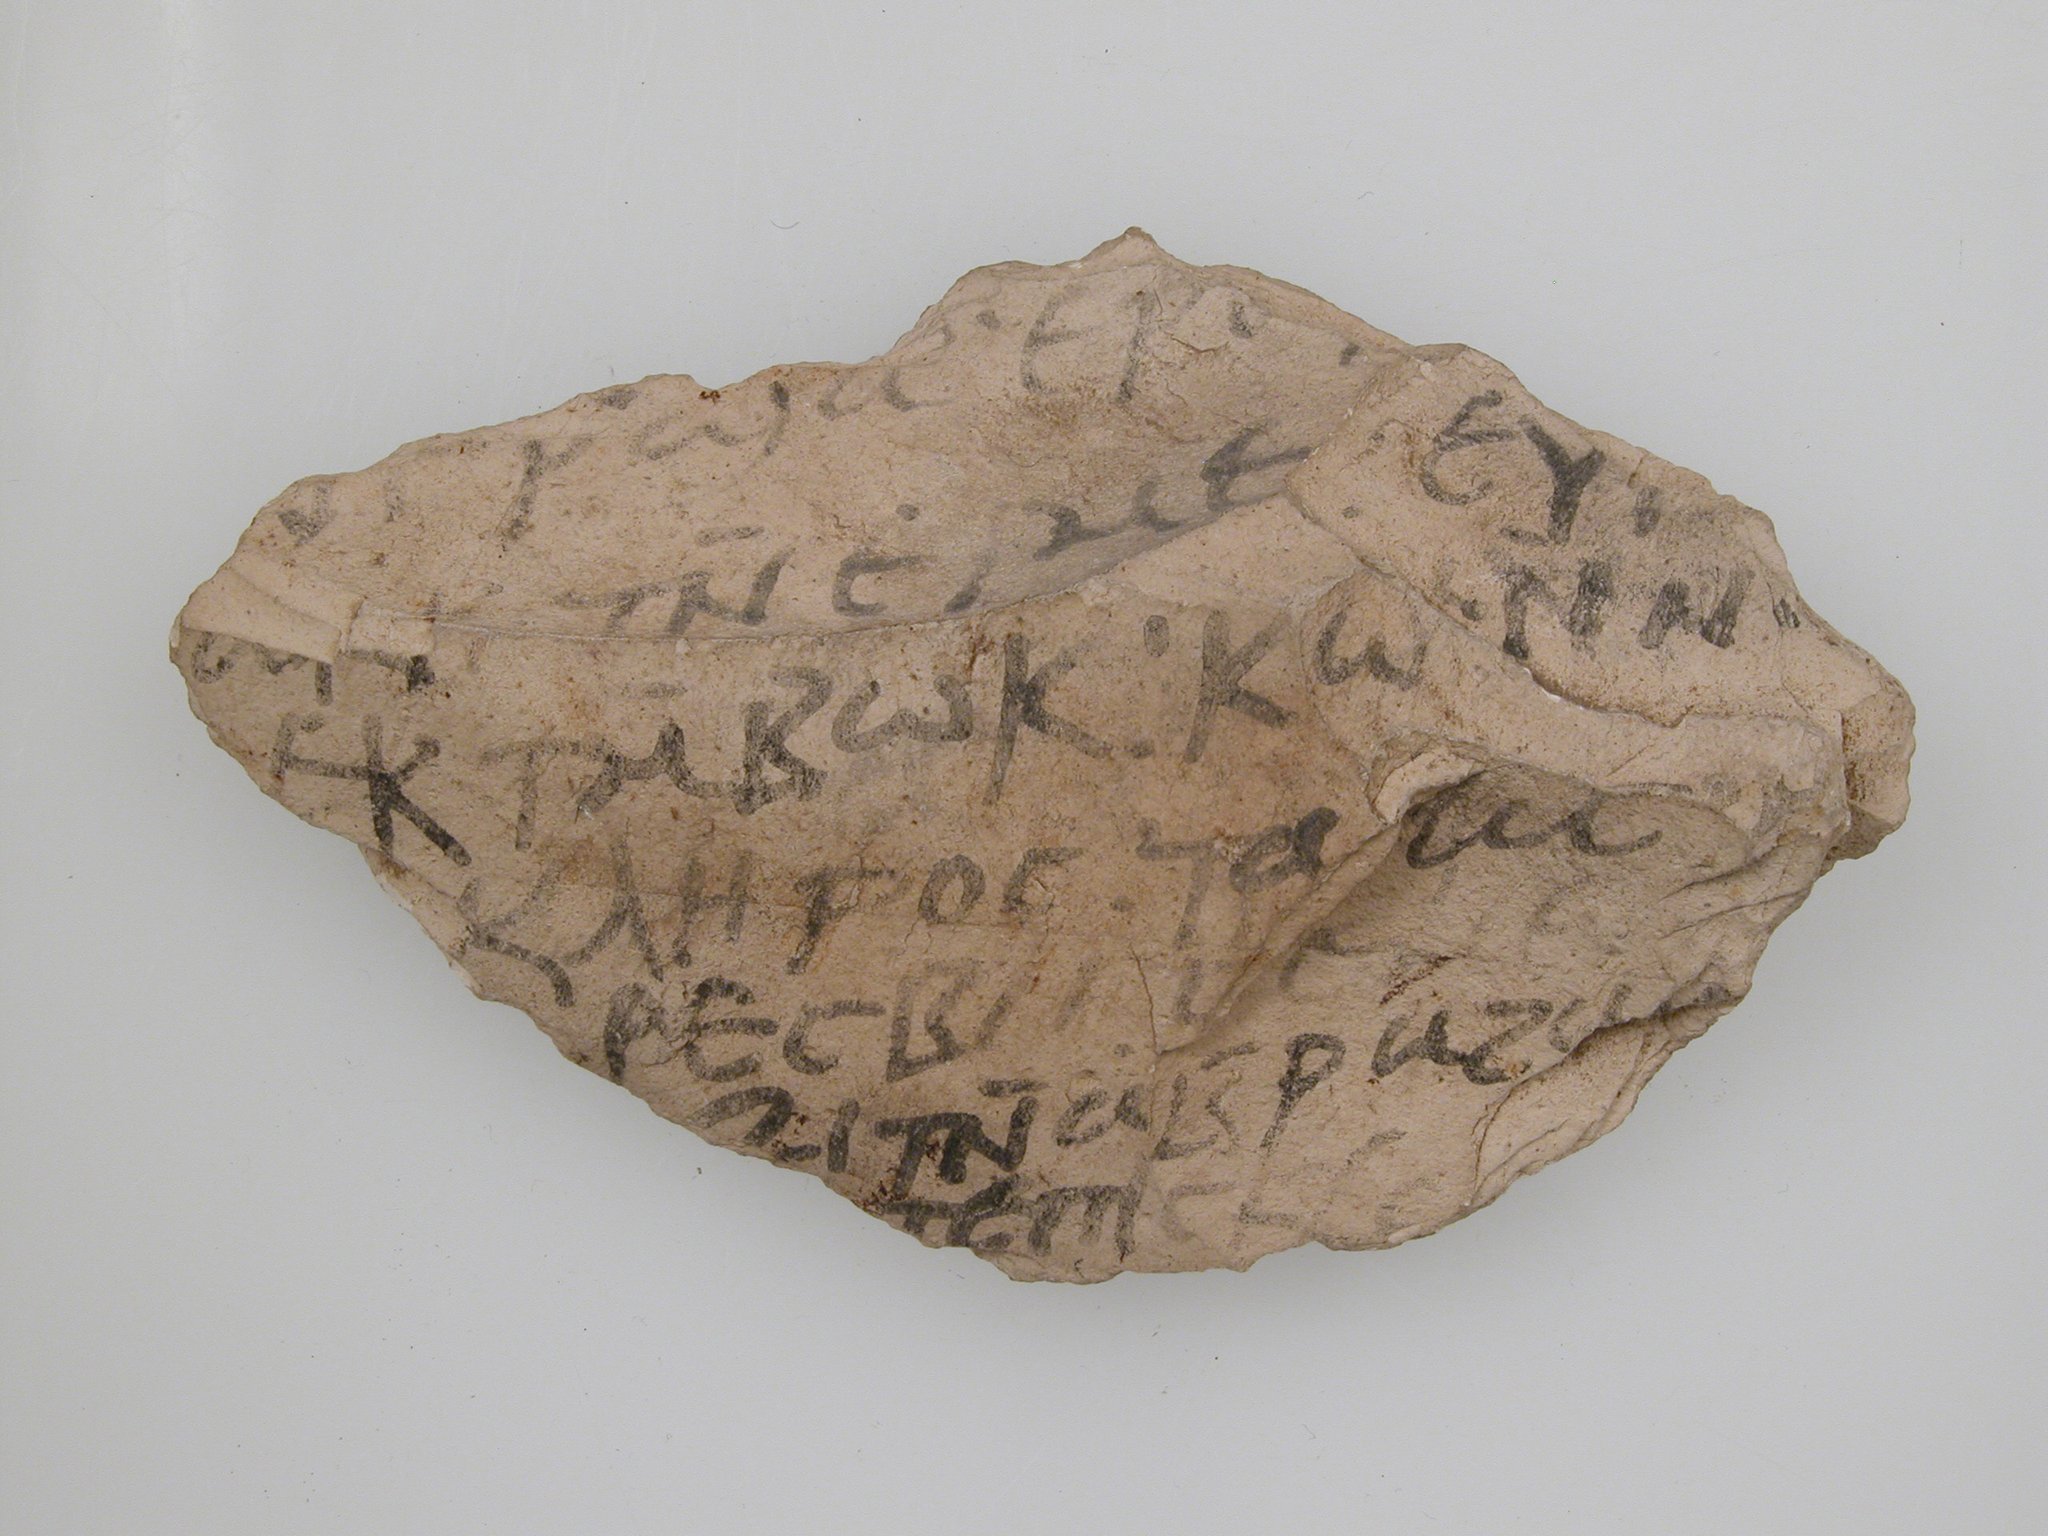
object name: ostrakon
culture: coptic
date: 601-700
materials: ink, limestone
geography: egypt